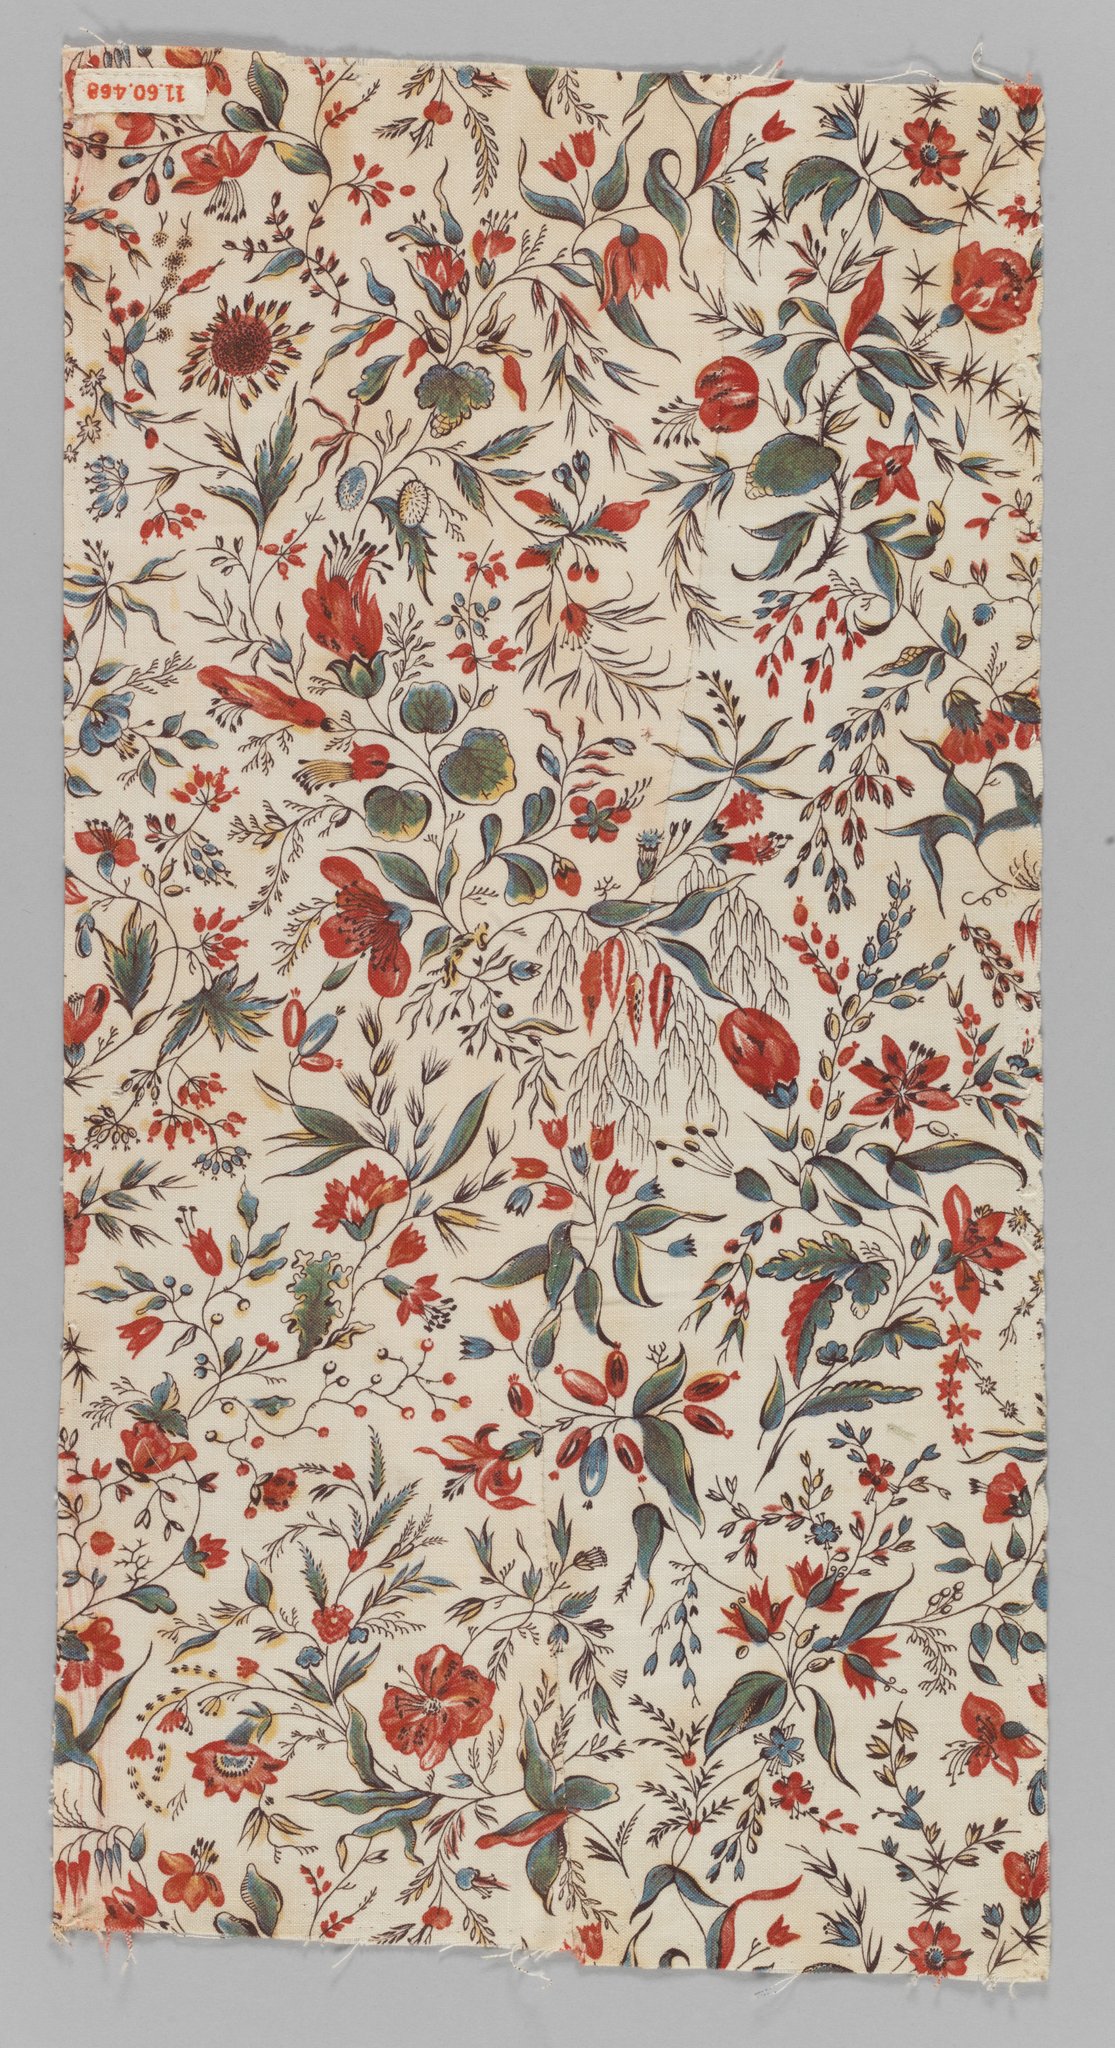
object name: piece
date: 1835-1840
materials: cotton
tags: flowers